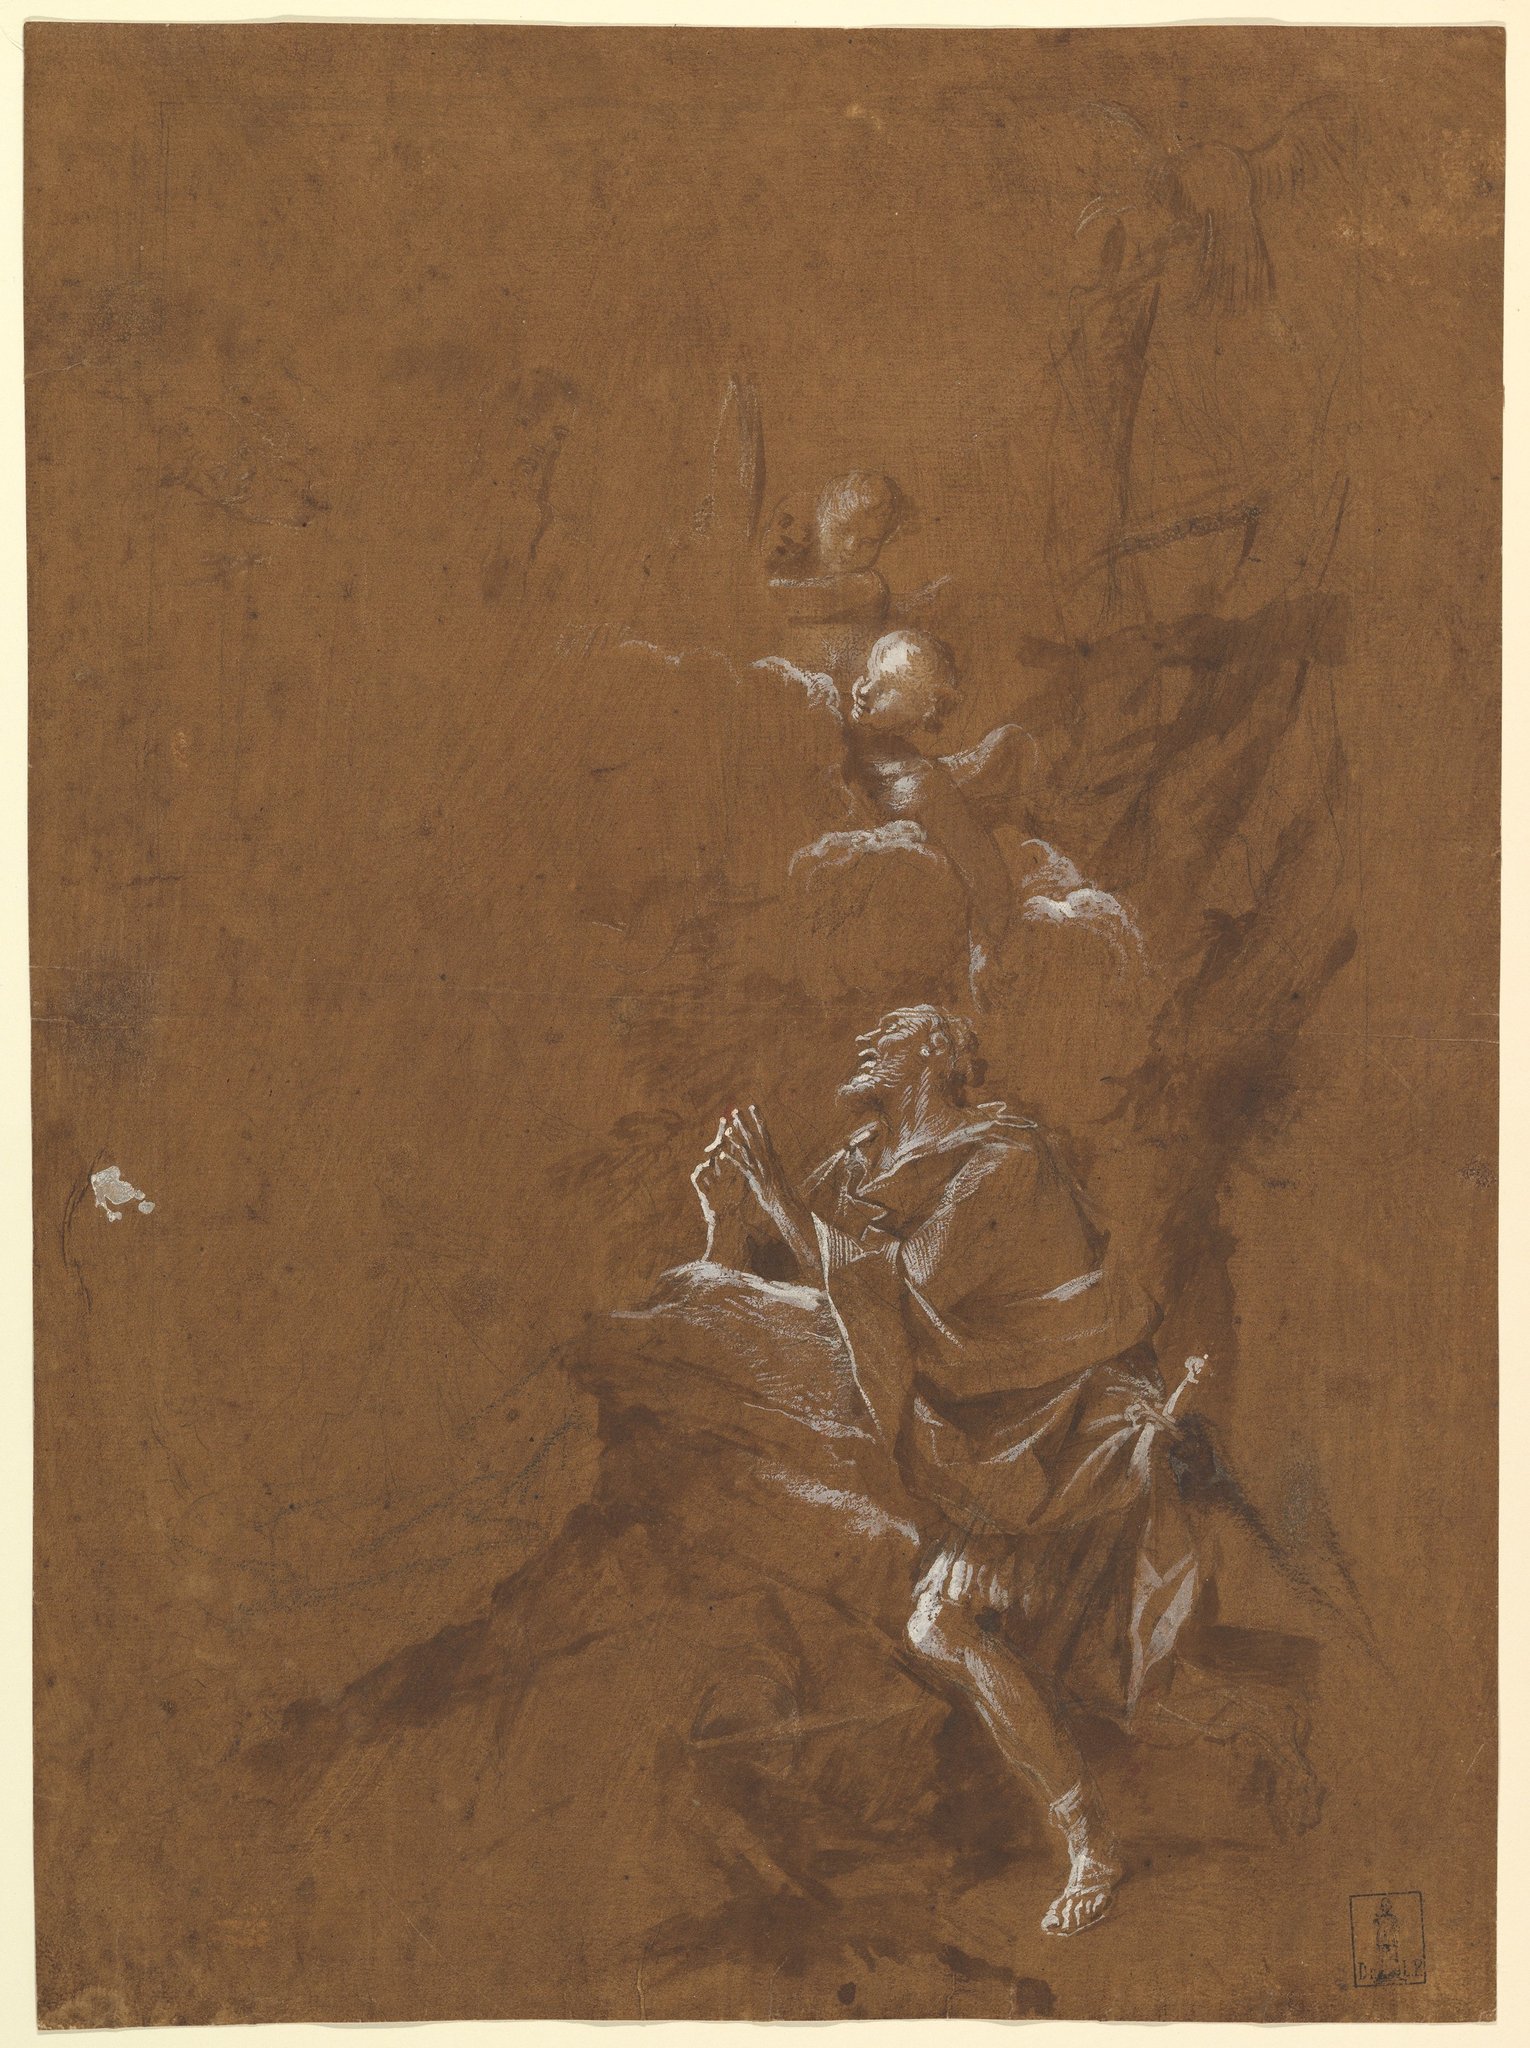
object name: drawing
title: The Vision of Saint William of Aquitaine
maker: giovanni angelo canini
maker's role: artist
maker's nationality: italian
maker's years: 1609-1666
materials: chalk, gouache, paper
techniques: brush, highlighting, wash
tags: saints